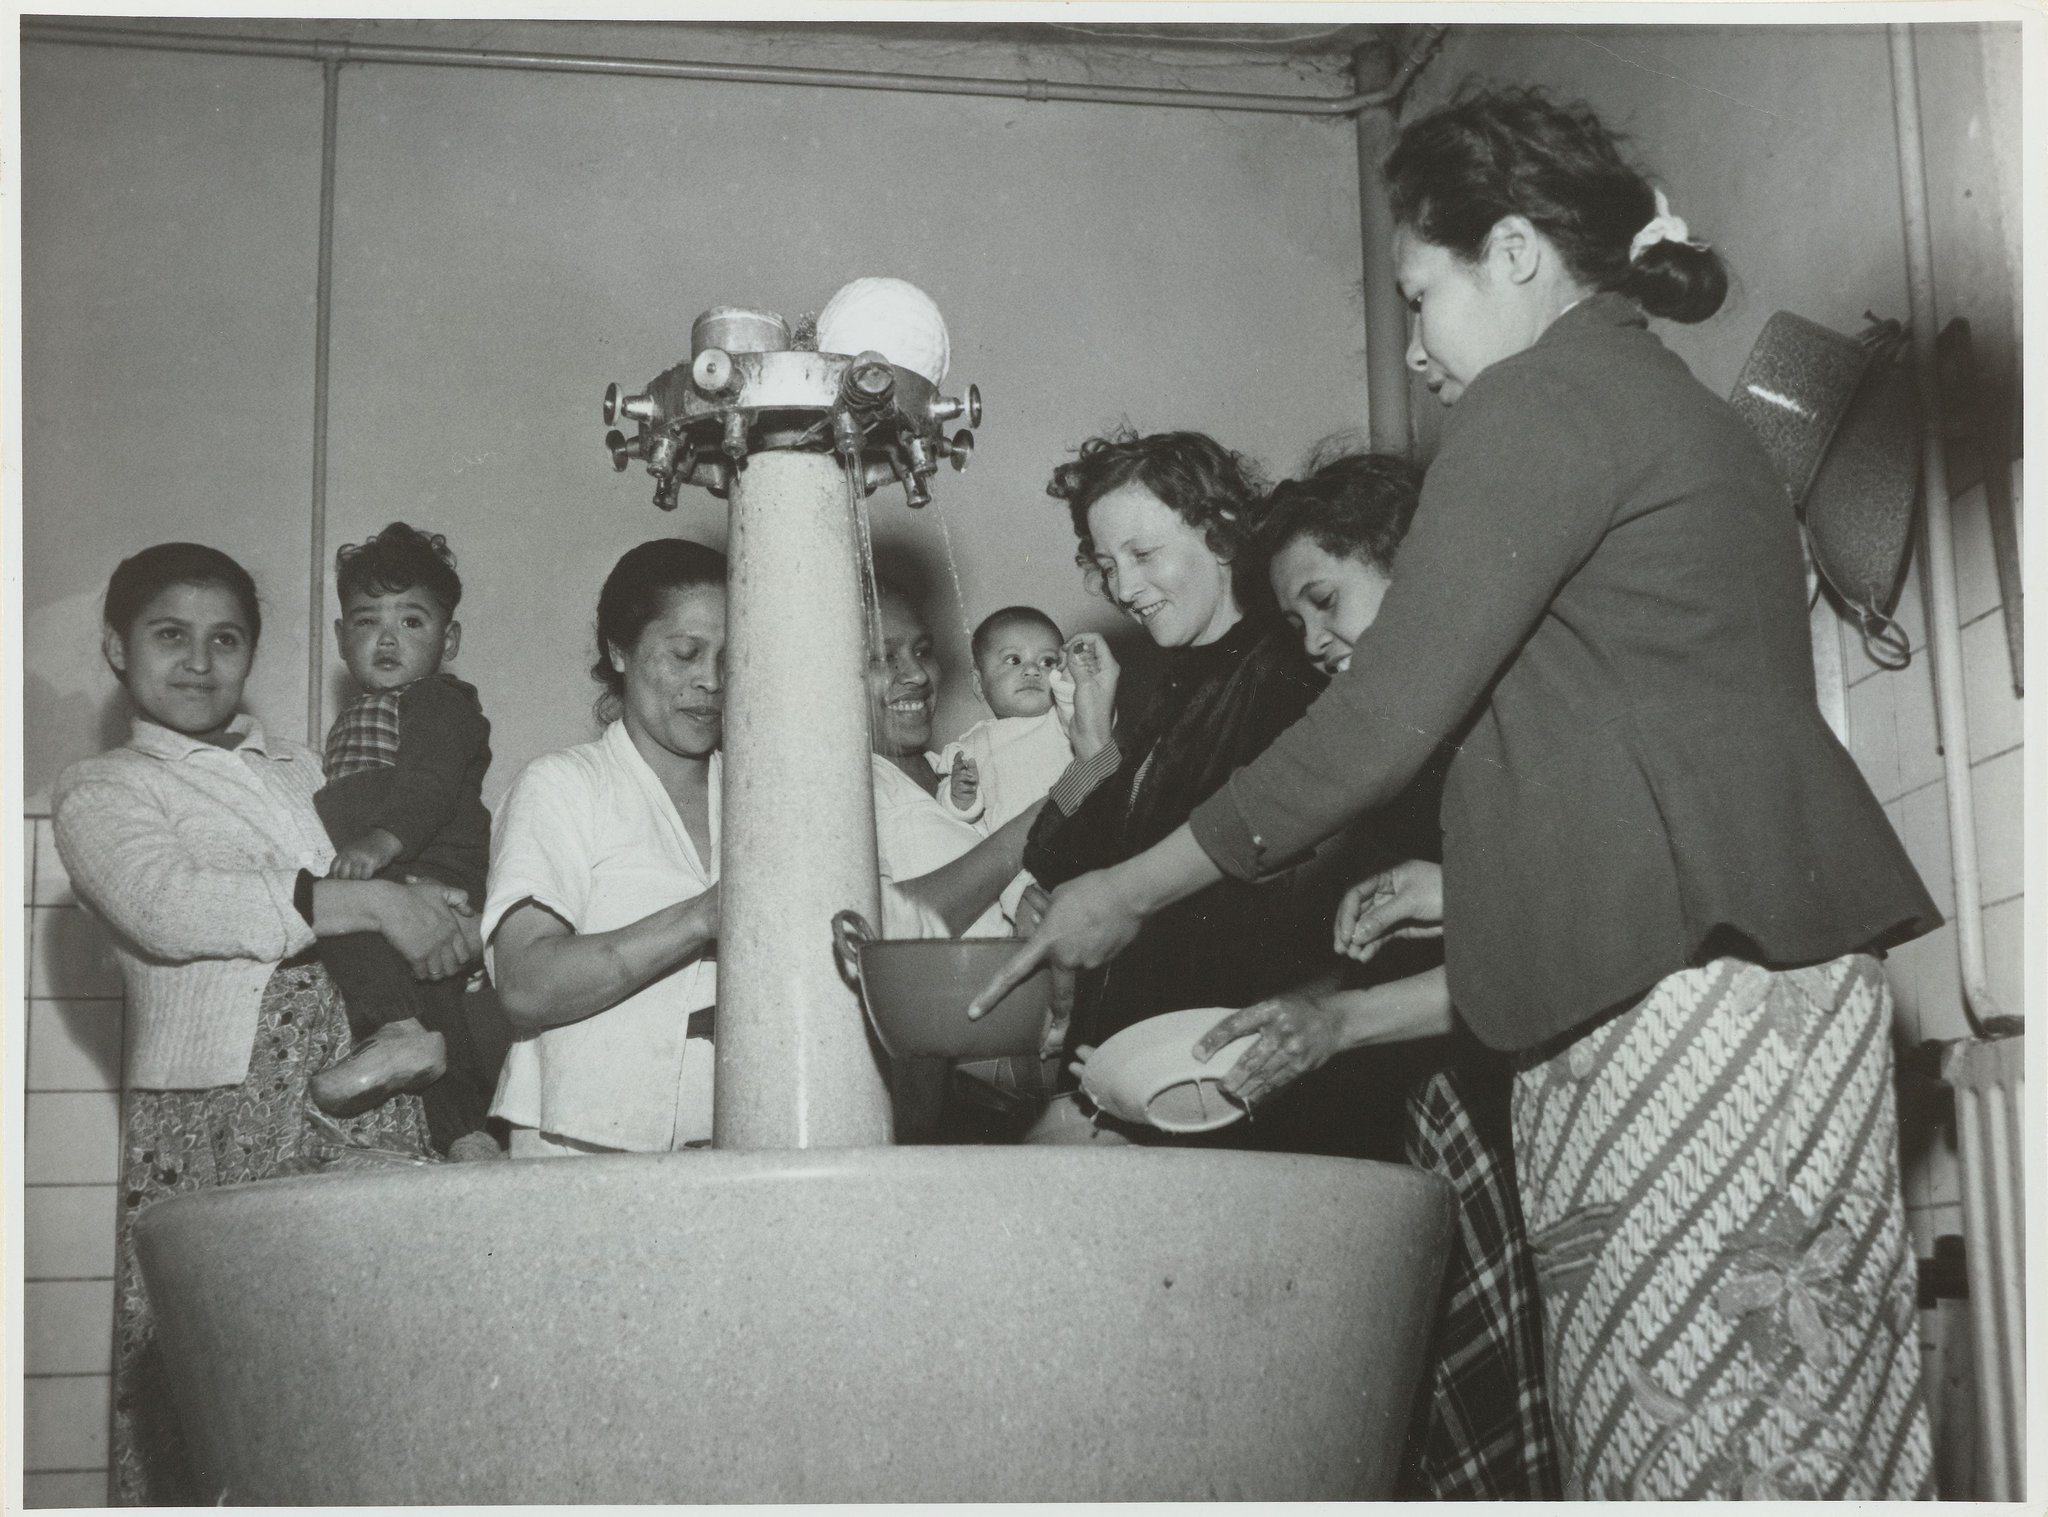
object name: photograph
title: Ambonese vrouwen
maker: e. de vries (fotograaf)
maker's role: fotograaf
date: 1951-1955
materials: photographic support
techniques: photography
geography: netherlands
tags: netherlands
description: Groep Ambonese vrouwen staat rond een ronde wasbak met in het midden een aantal kranen. Zij krijgen van een Nederlandse vrouw aanwijzingen